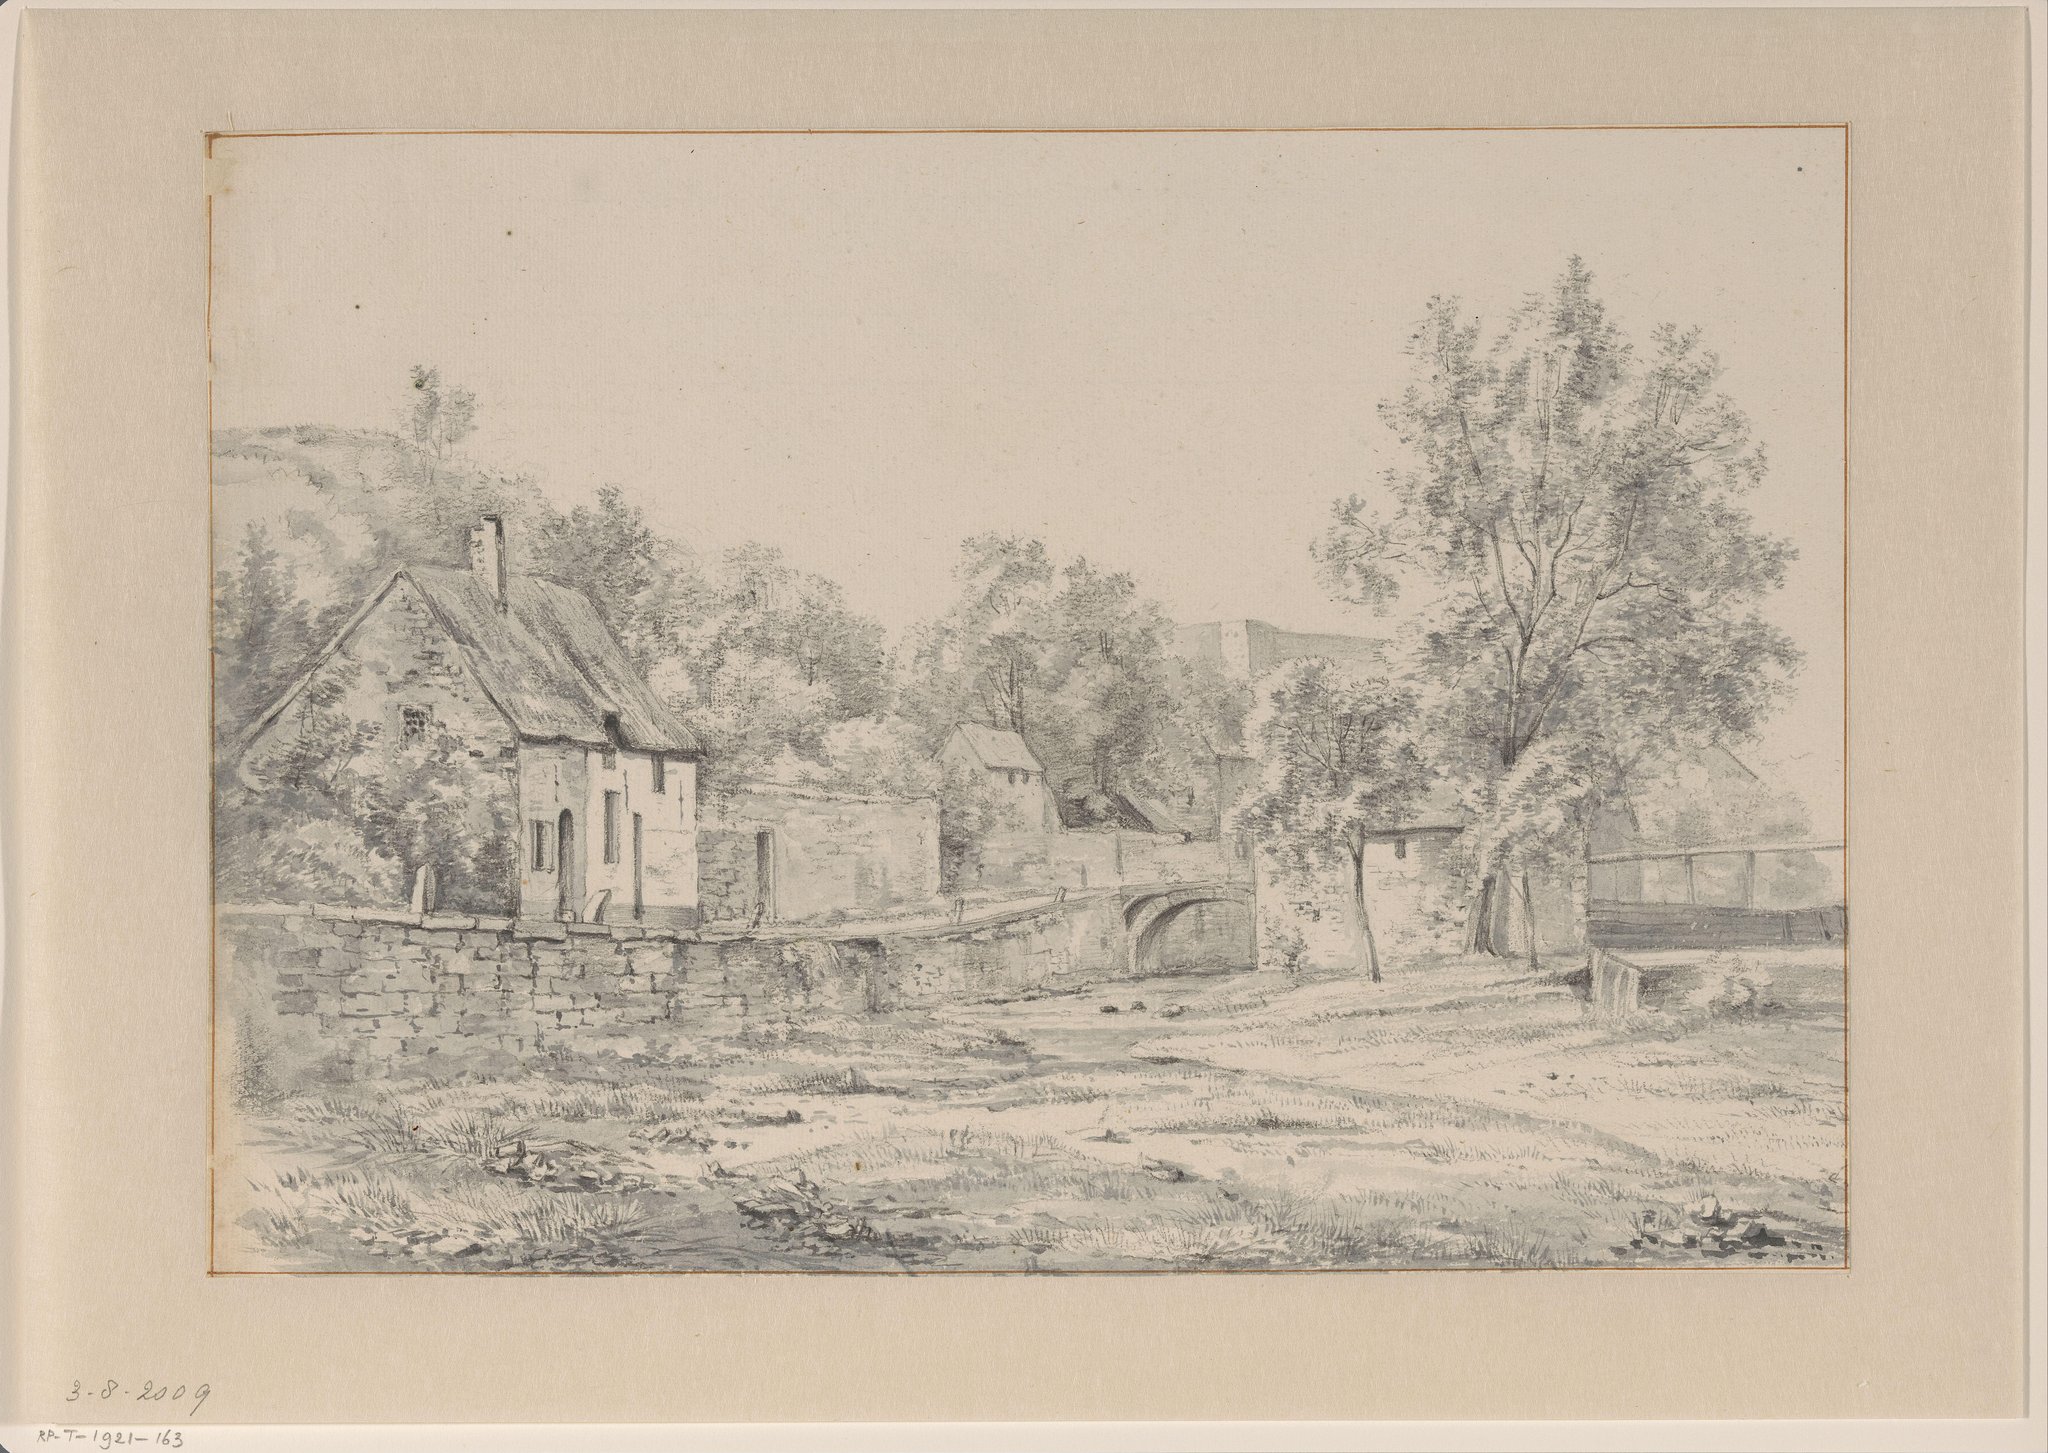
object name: drawing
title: Dorpsgezicht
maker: jan andries töpfer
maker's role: draughtsman, print maker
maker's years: 1792-1841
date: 1802-1841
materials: chalk, paper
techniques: brush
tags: village